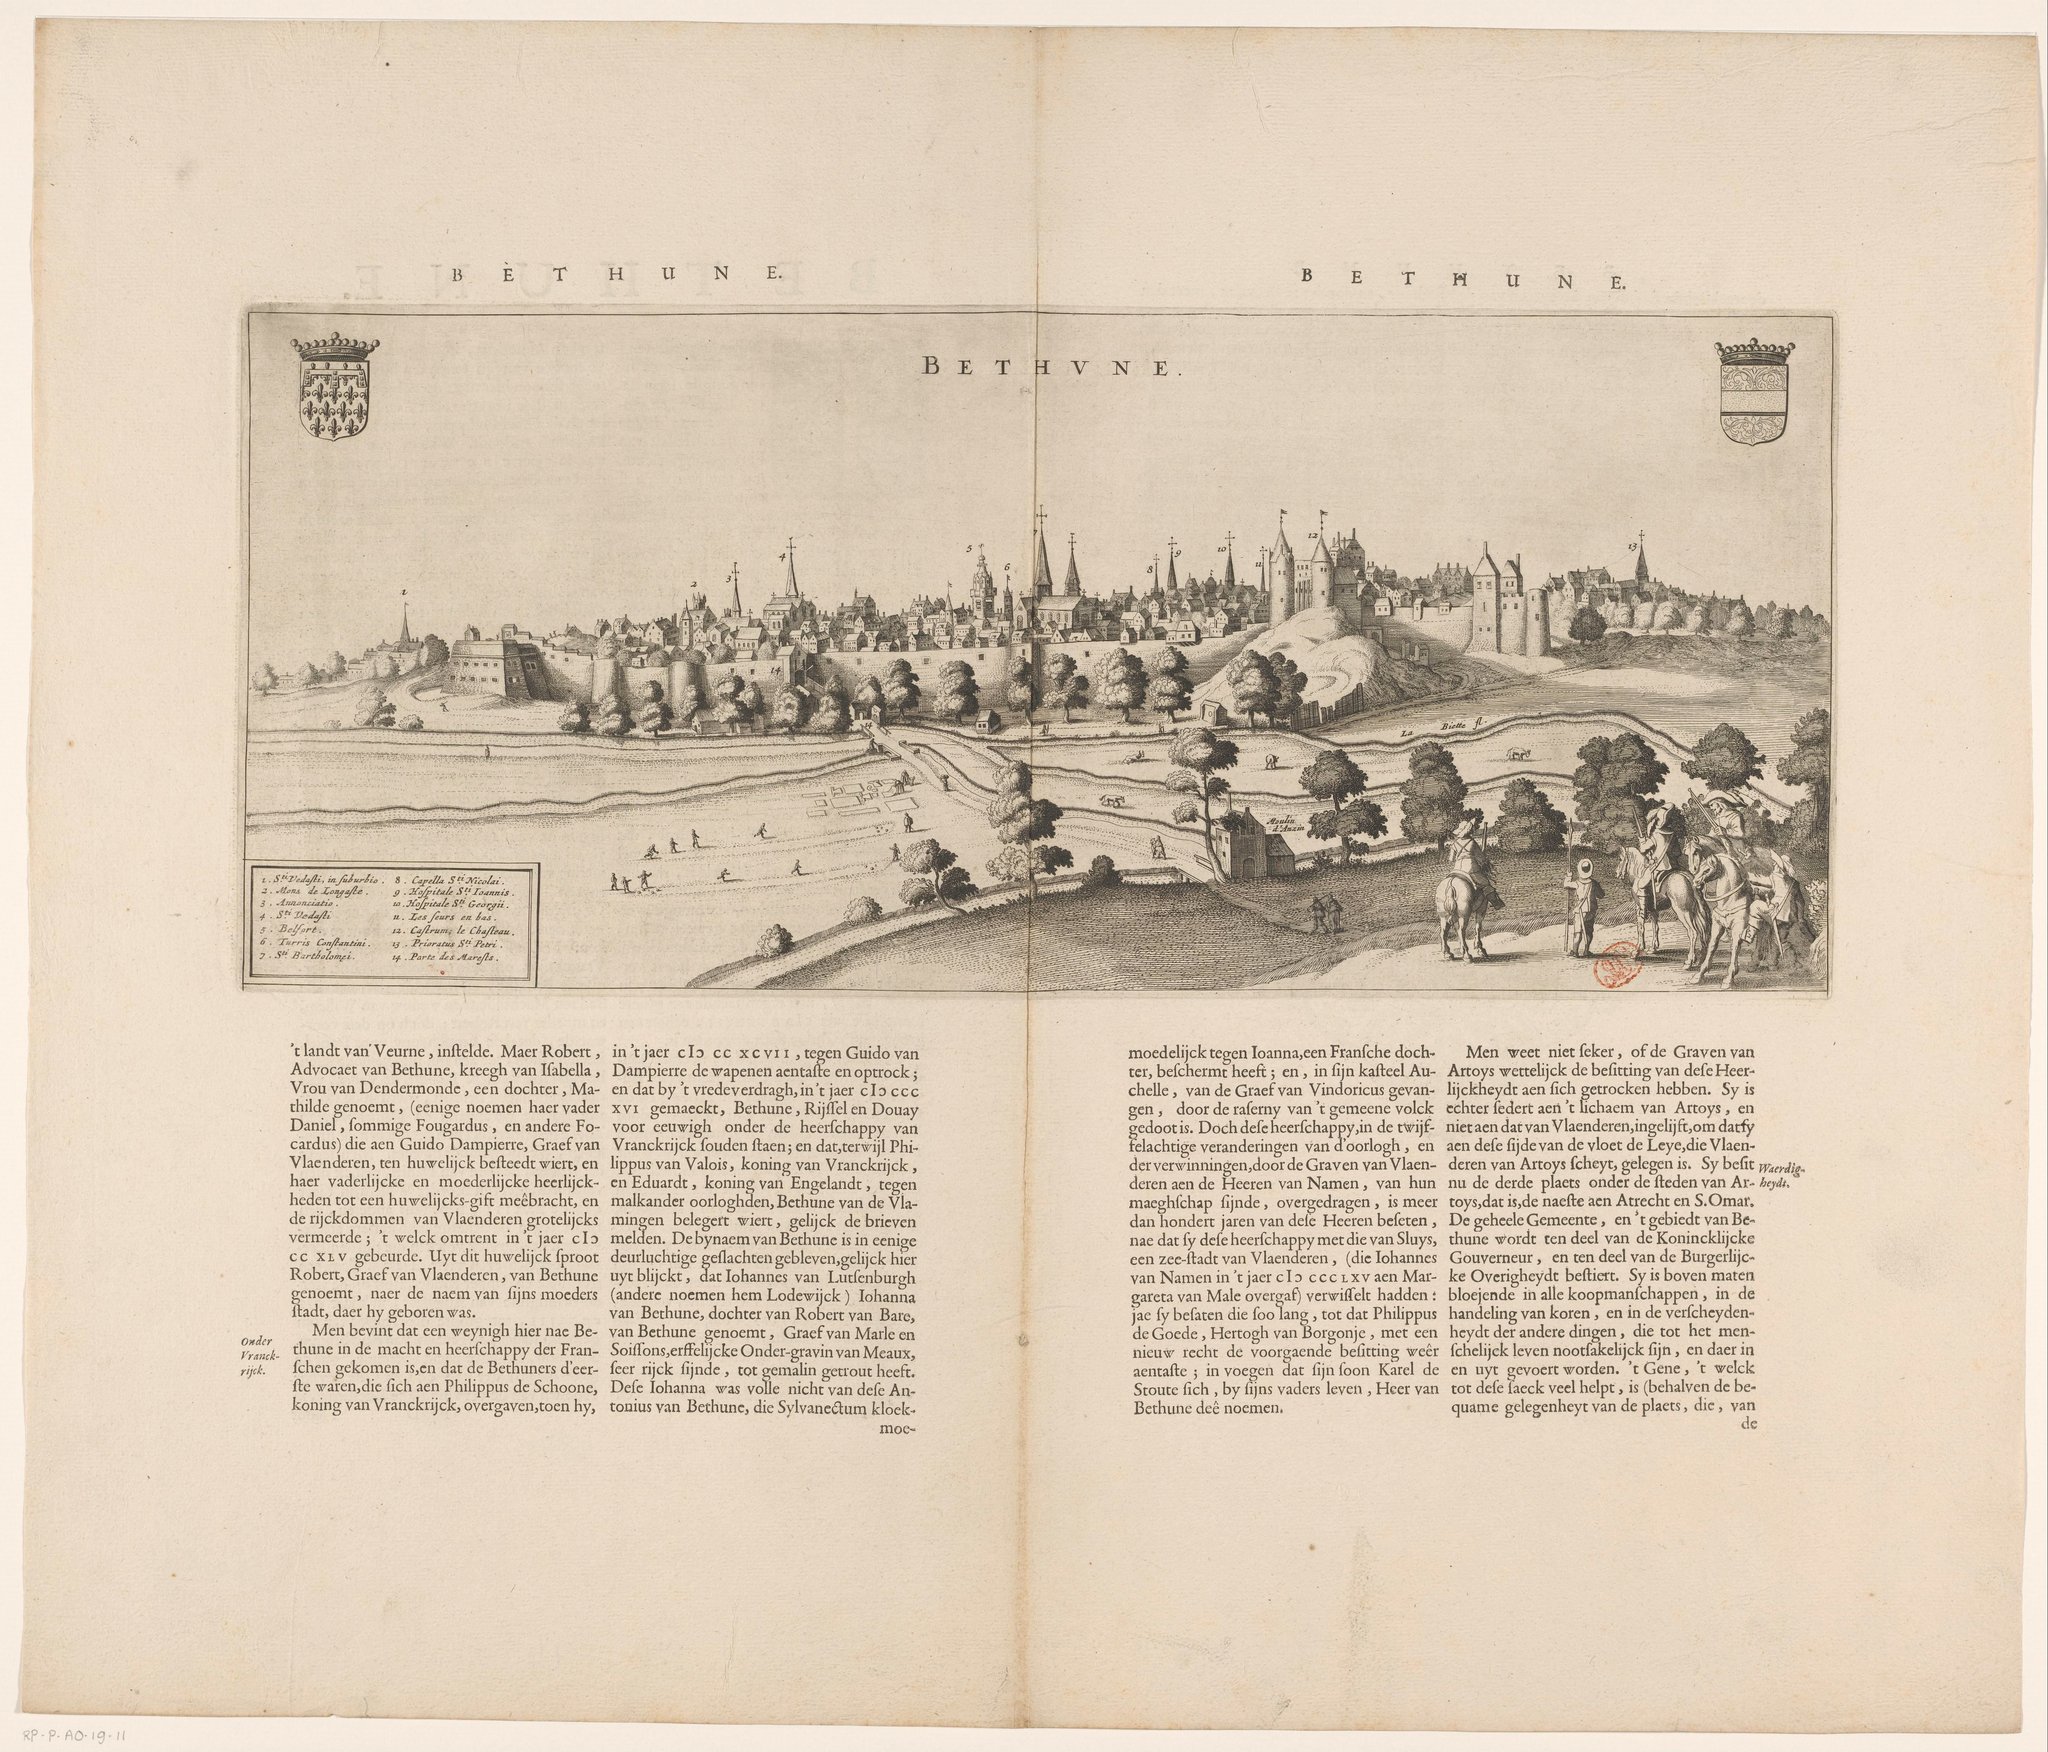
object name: print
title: Gezicht op en beschrijving van Béthune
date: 1652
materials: paper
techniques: engraving, etching, letterpress printing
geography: amsterdam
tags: coat of arms (as symbol of the state, etc.) (+ city; municipal), coat of arms (as symbol of the state, etc.) (+ province; provincial), prospect of city, town panorama, silhouette of city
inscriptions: collector's mark: Lugt 195, collector's mark: Lugt 2228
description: Gezicht op en beschrijving van Béthune. Linksboven in het gezicht op Béthune het wapen van het graafschap Artesië. Rechtsboven het wapen van Béthune. Linksonder een kader met legenda 1-14. Met Nederlandse tekst op verso.